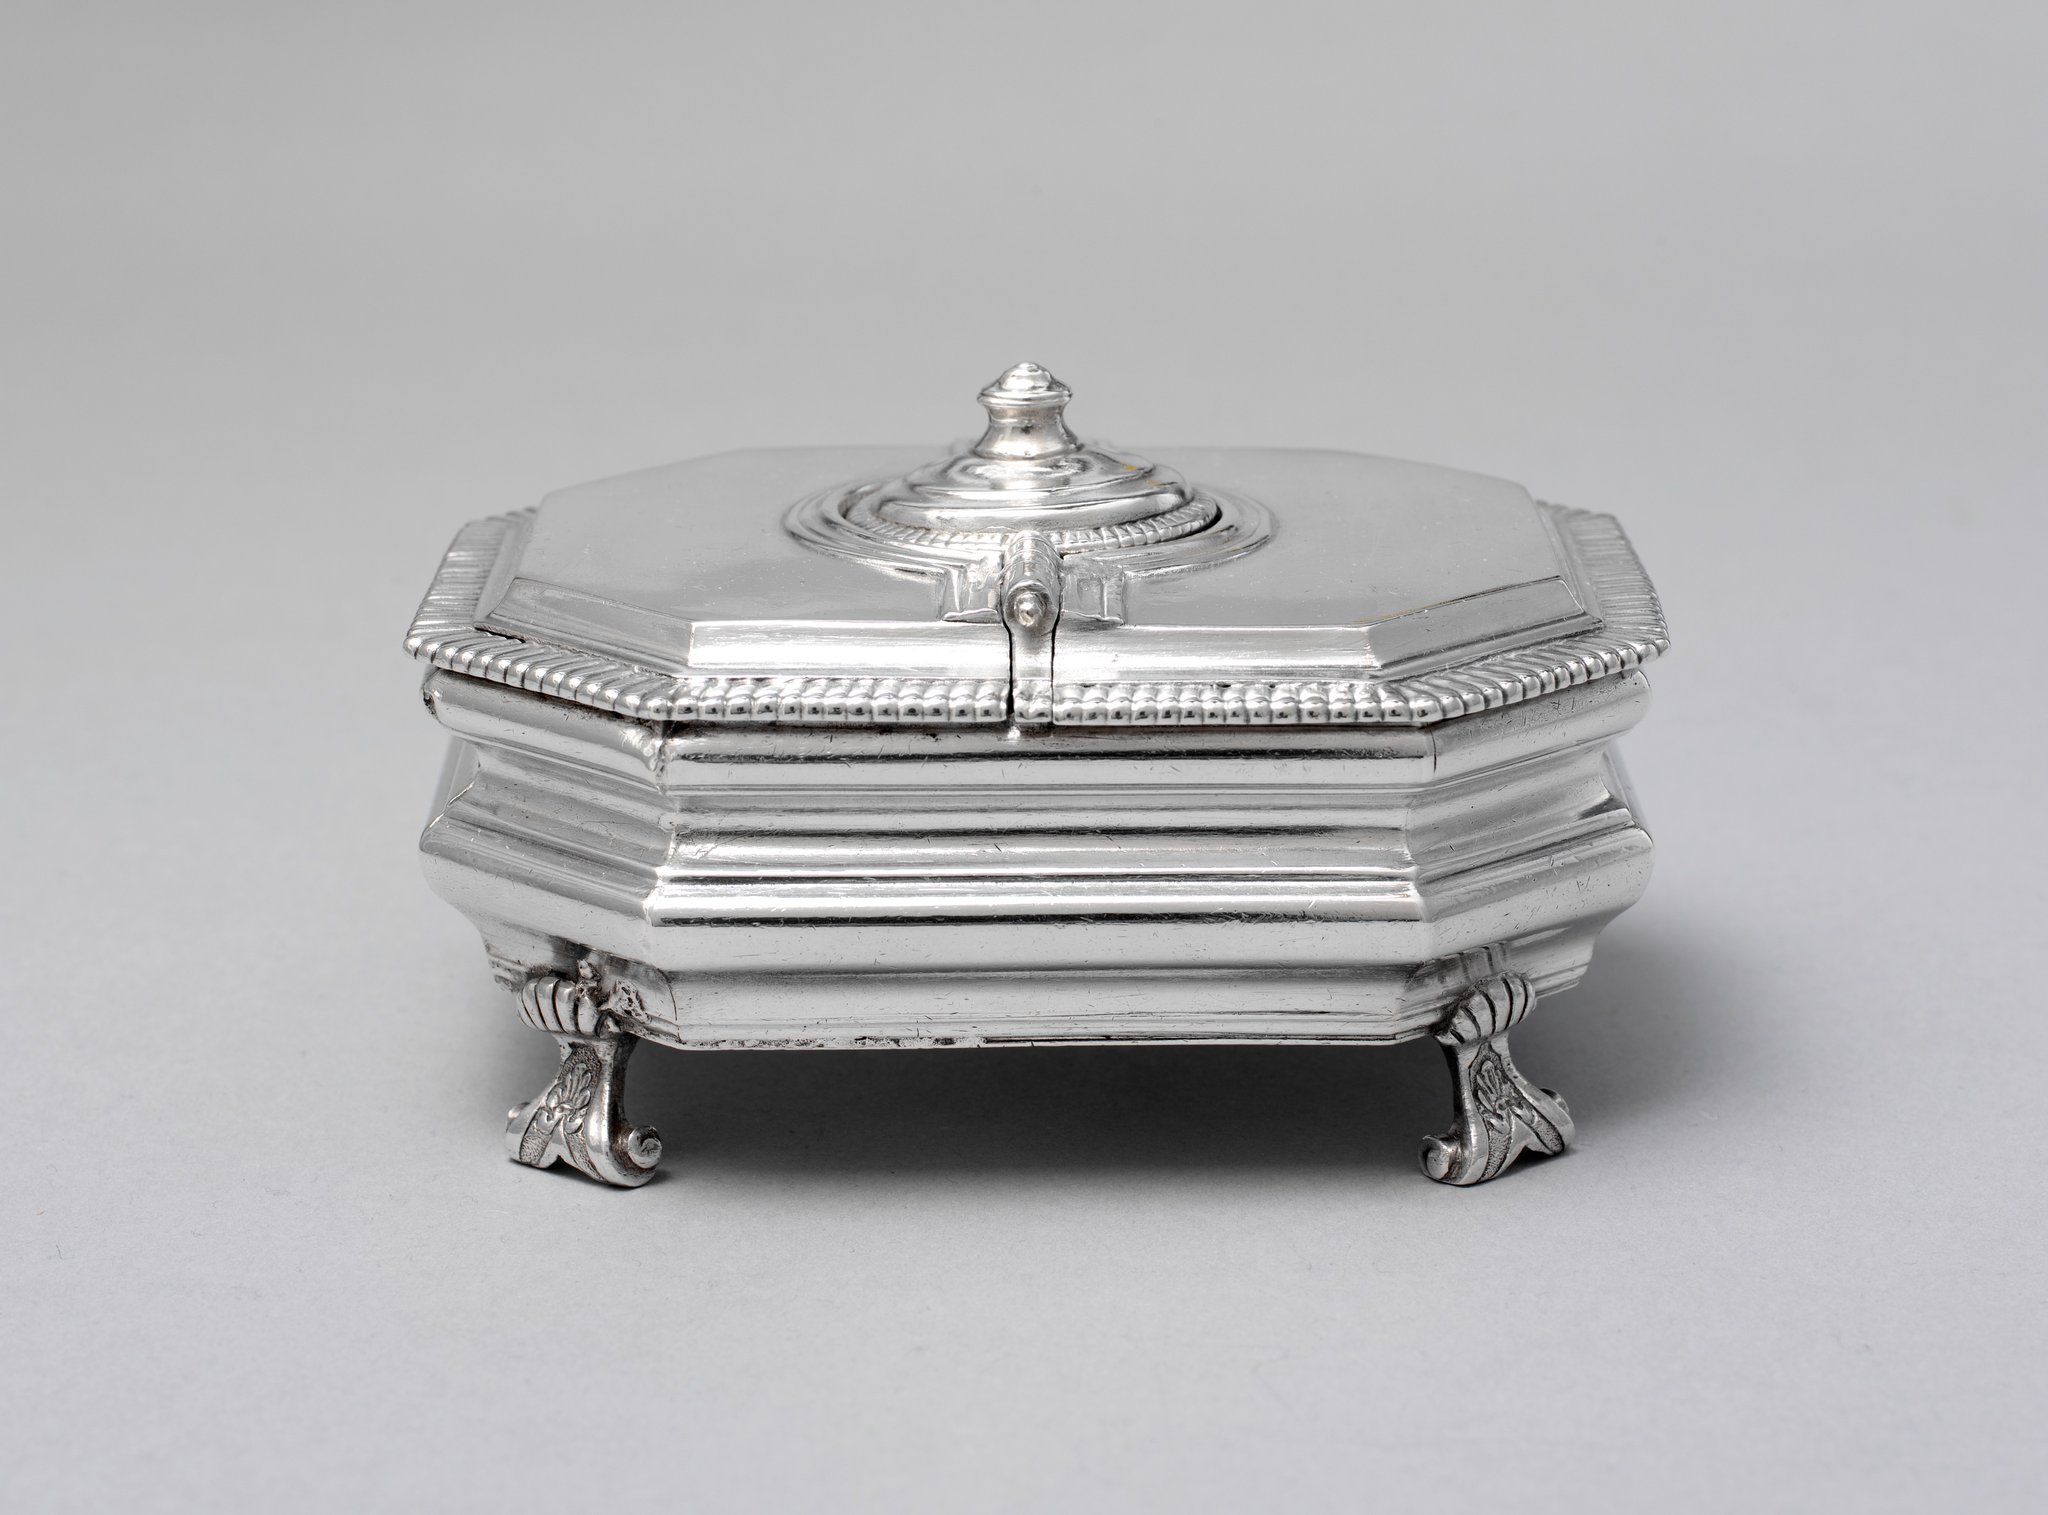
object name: spice box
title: Spice box with grater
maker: nicolas ii boullet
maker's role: maker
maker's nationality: french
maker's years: 1675-1758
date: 1730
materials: silver